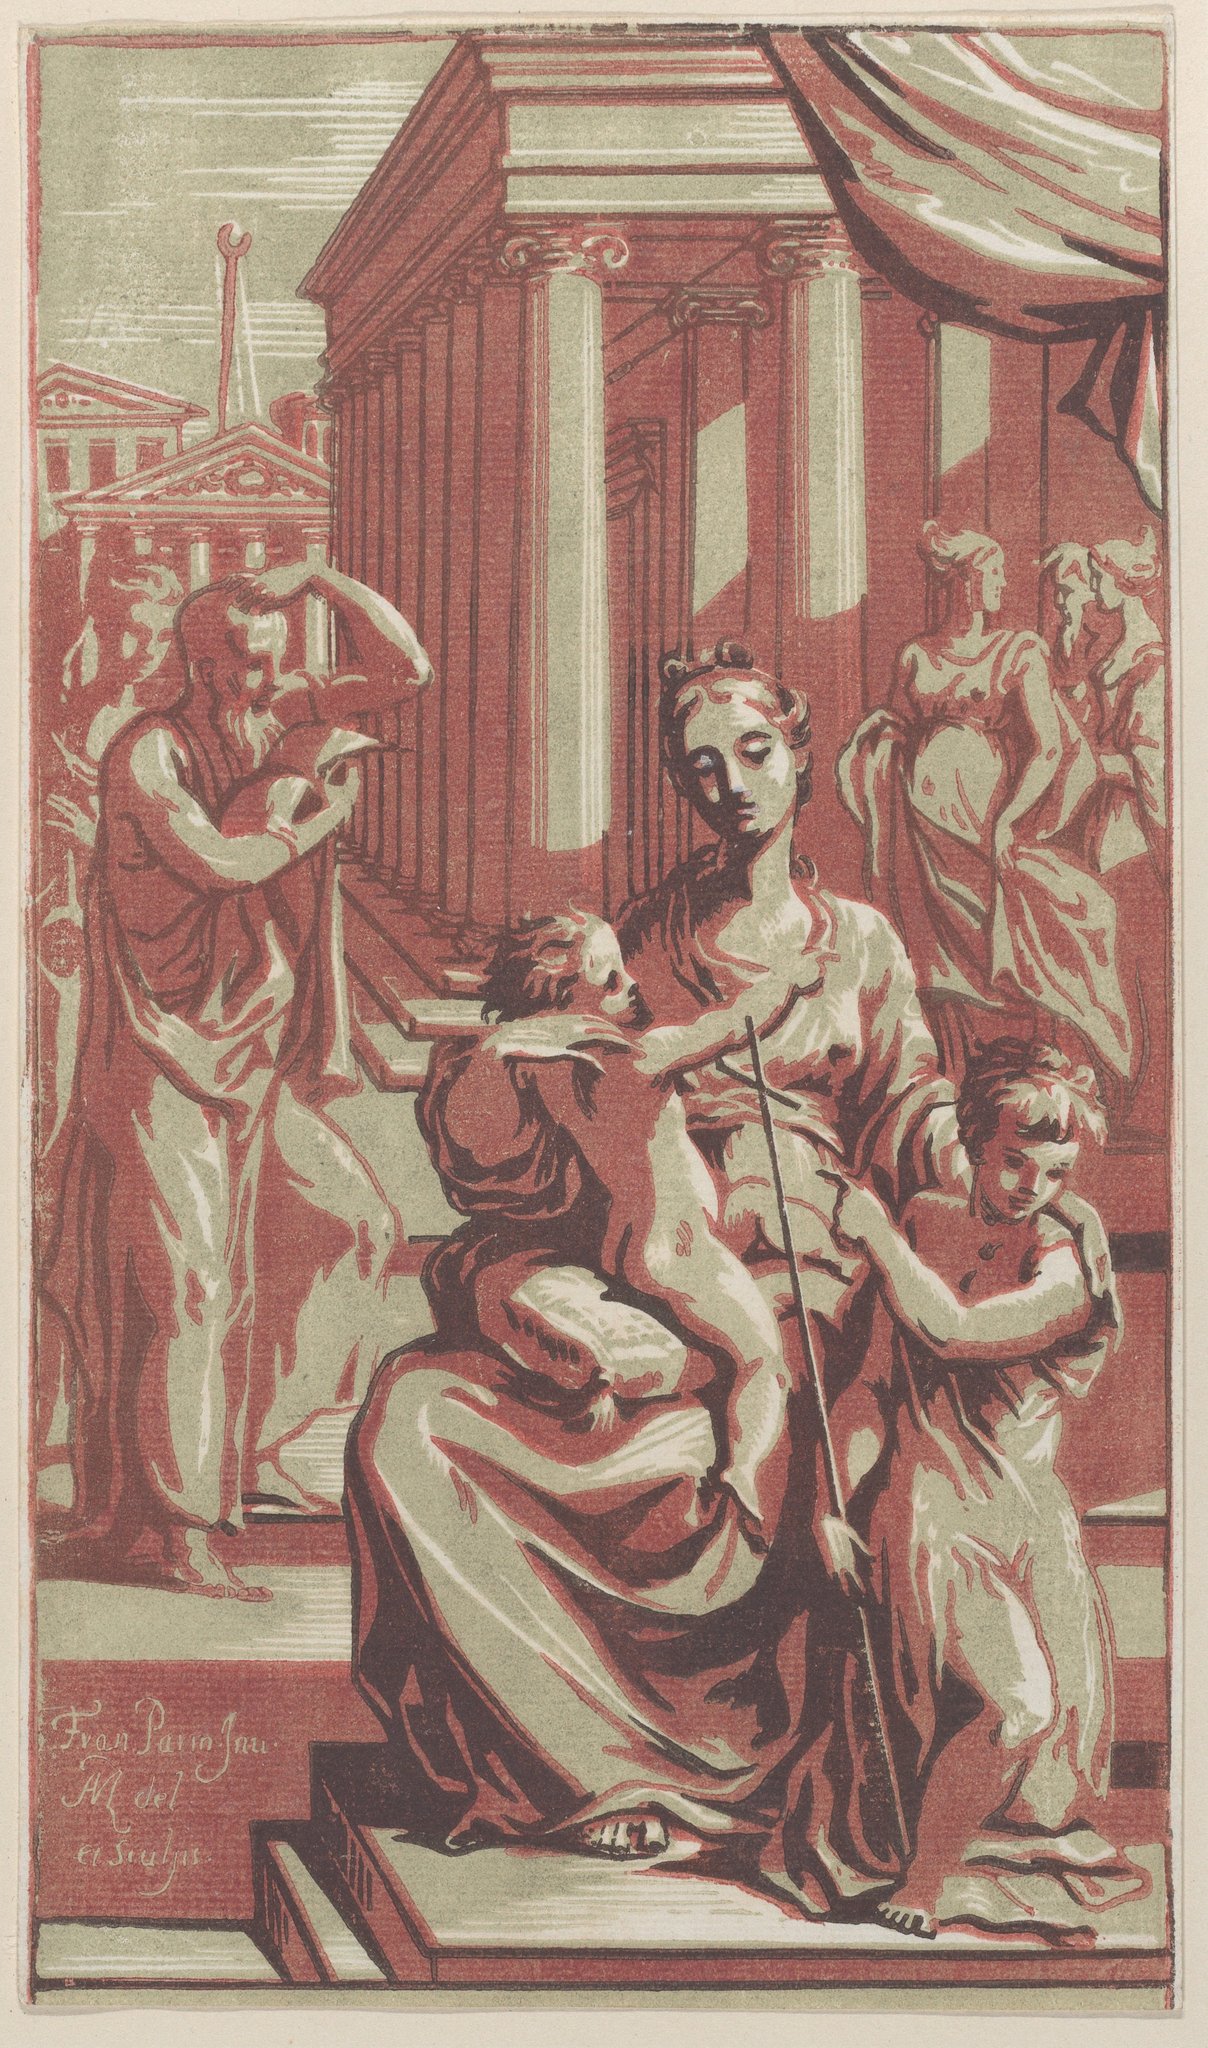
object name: print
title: The Virgin and Child with Saint John the Baptist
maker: conte anton maria zanetti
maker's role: artist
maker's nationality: italian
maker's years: 1680-1767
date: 1722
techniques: woodcut